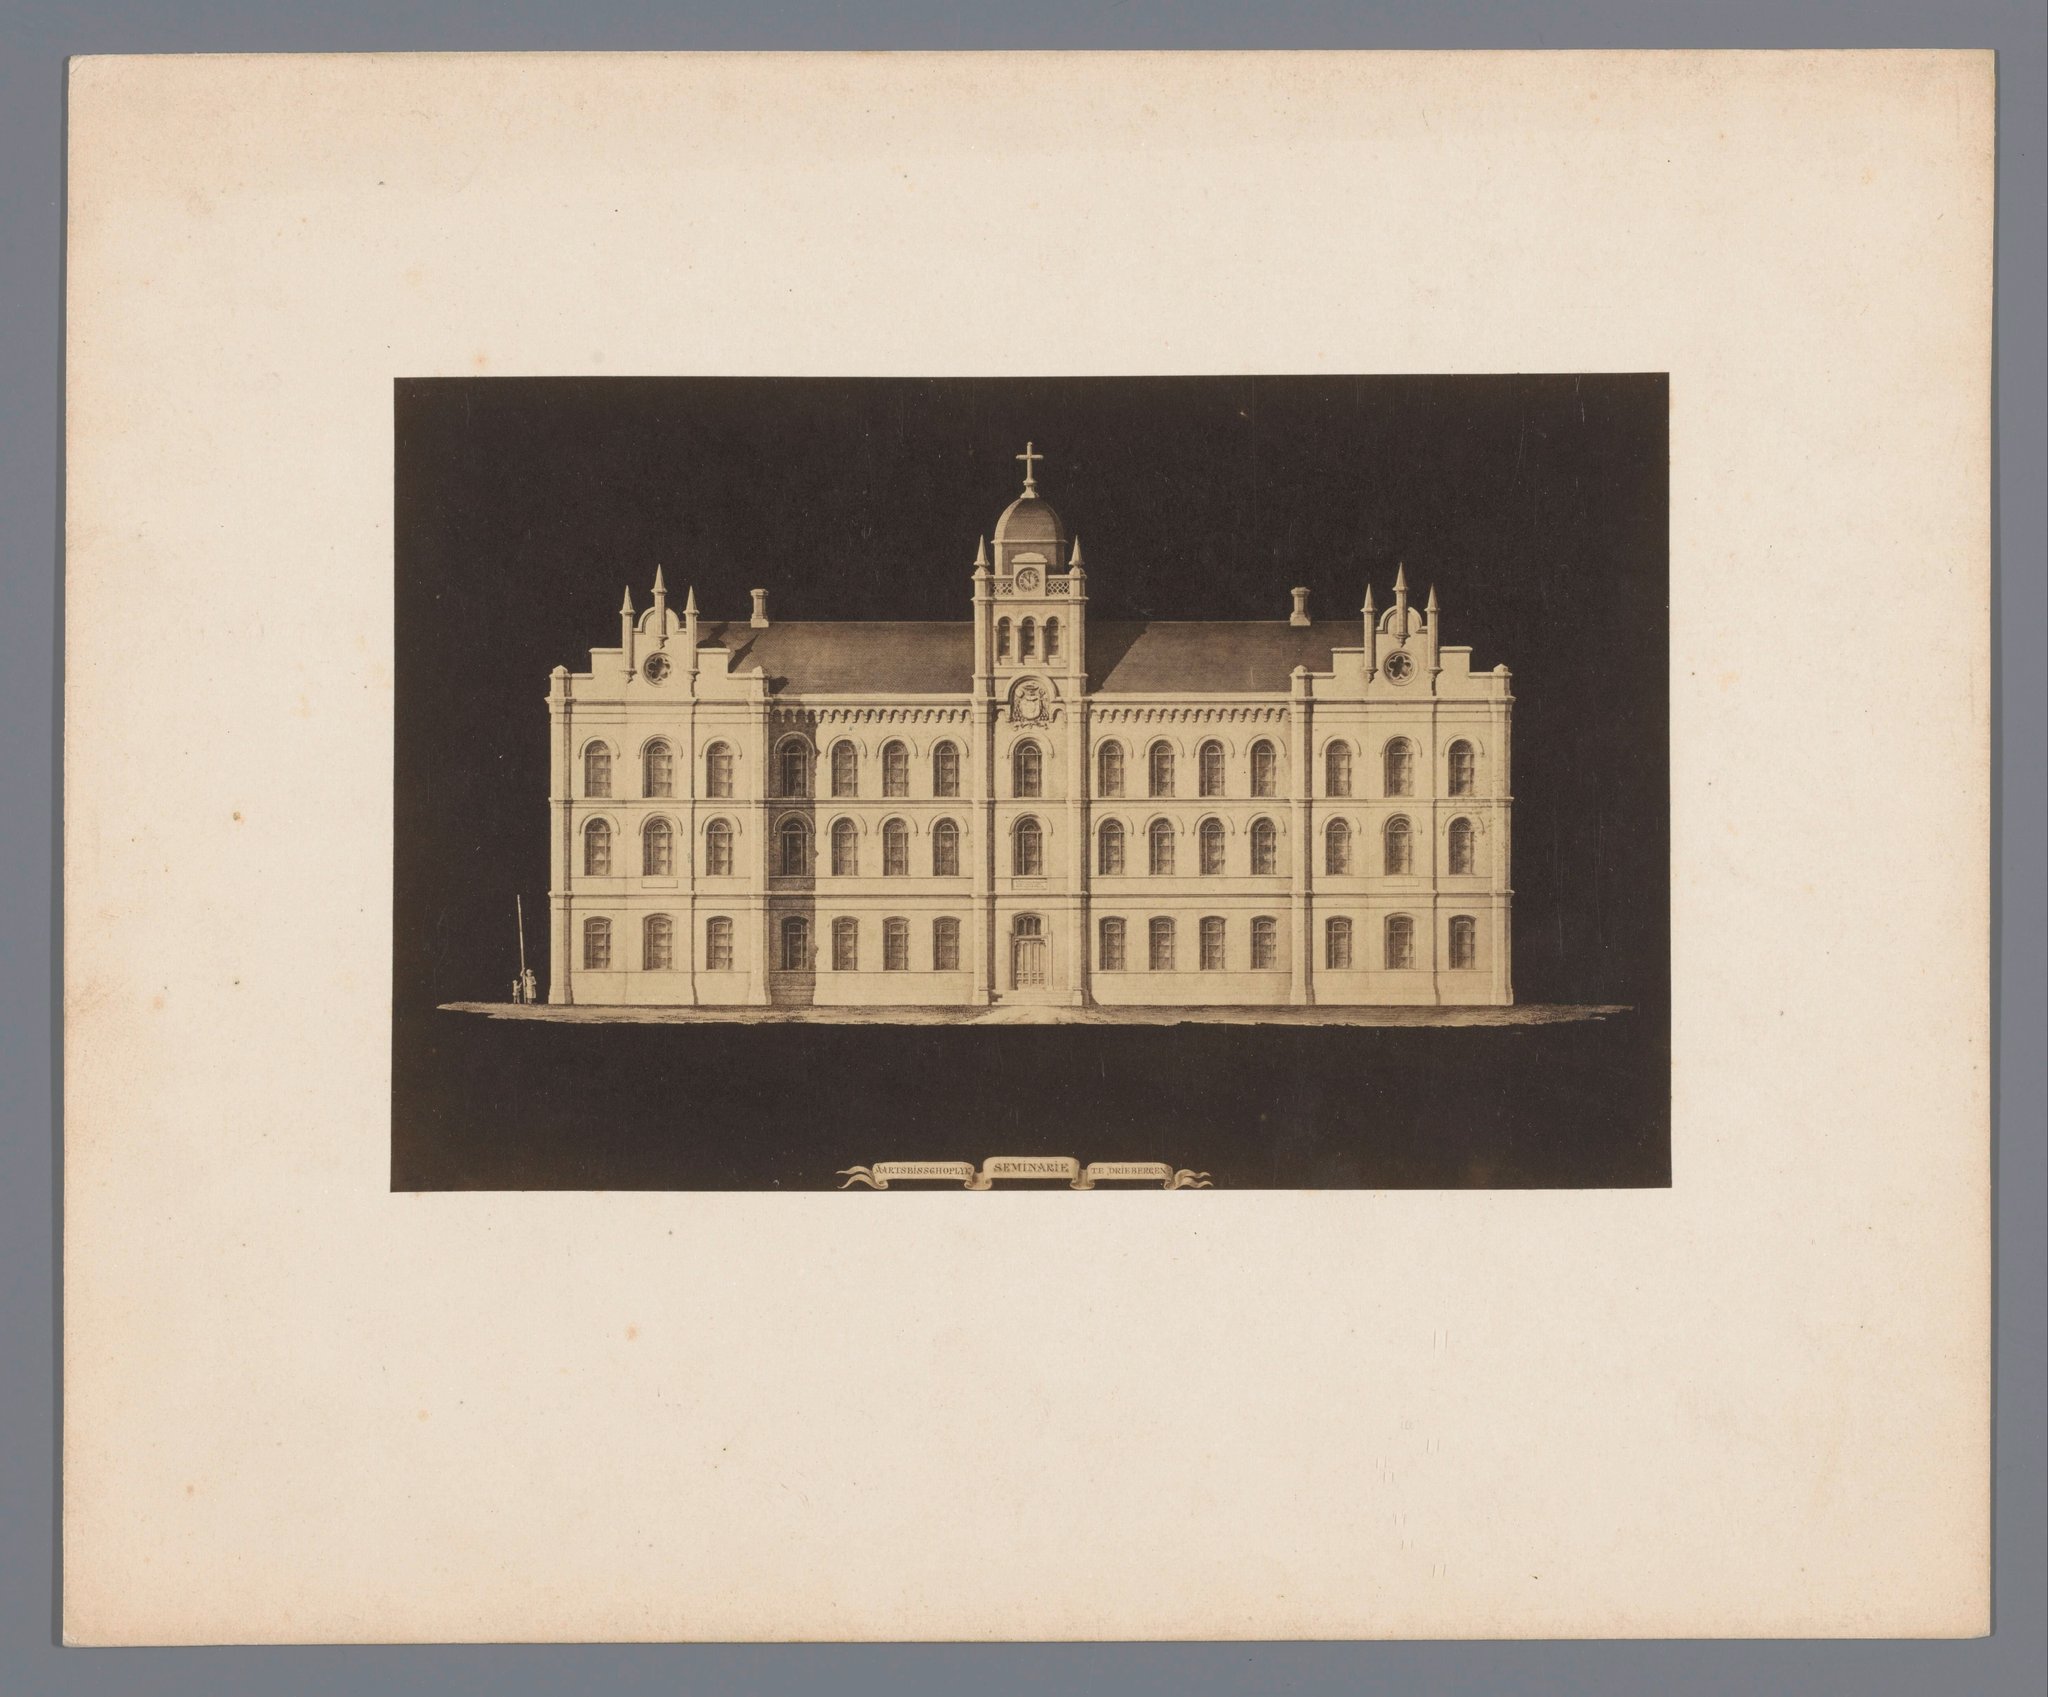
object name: photograph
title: Tekening van het Aarstbisschoppelijk Seminarie te Driebergen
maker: abraham adrianus vermeulen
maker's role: painter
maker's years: 1817-1894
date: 1860-1880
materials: cardboard, paper, photographic support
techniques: albumen print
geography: utrecht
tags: institution for ecclesiastical education and training, e.g. seminary